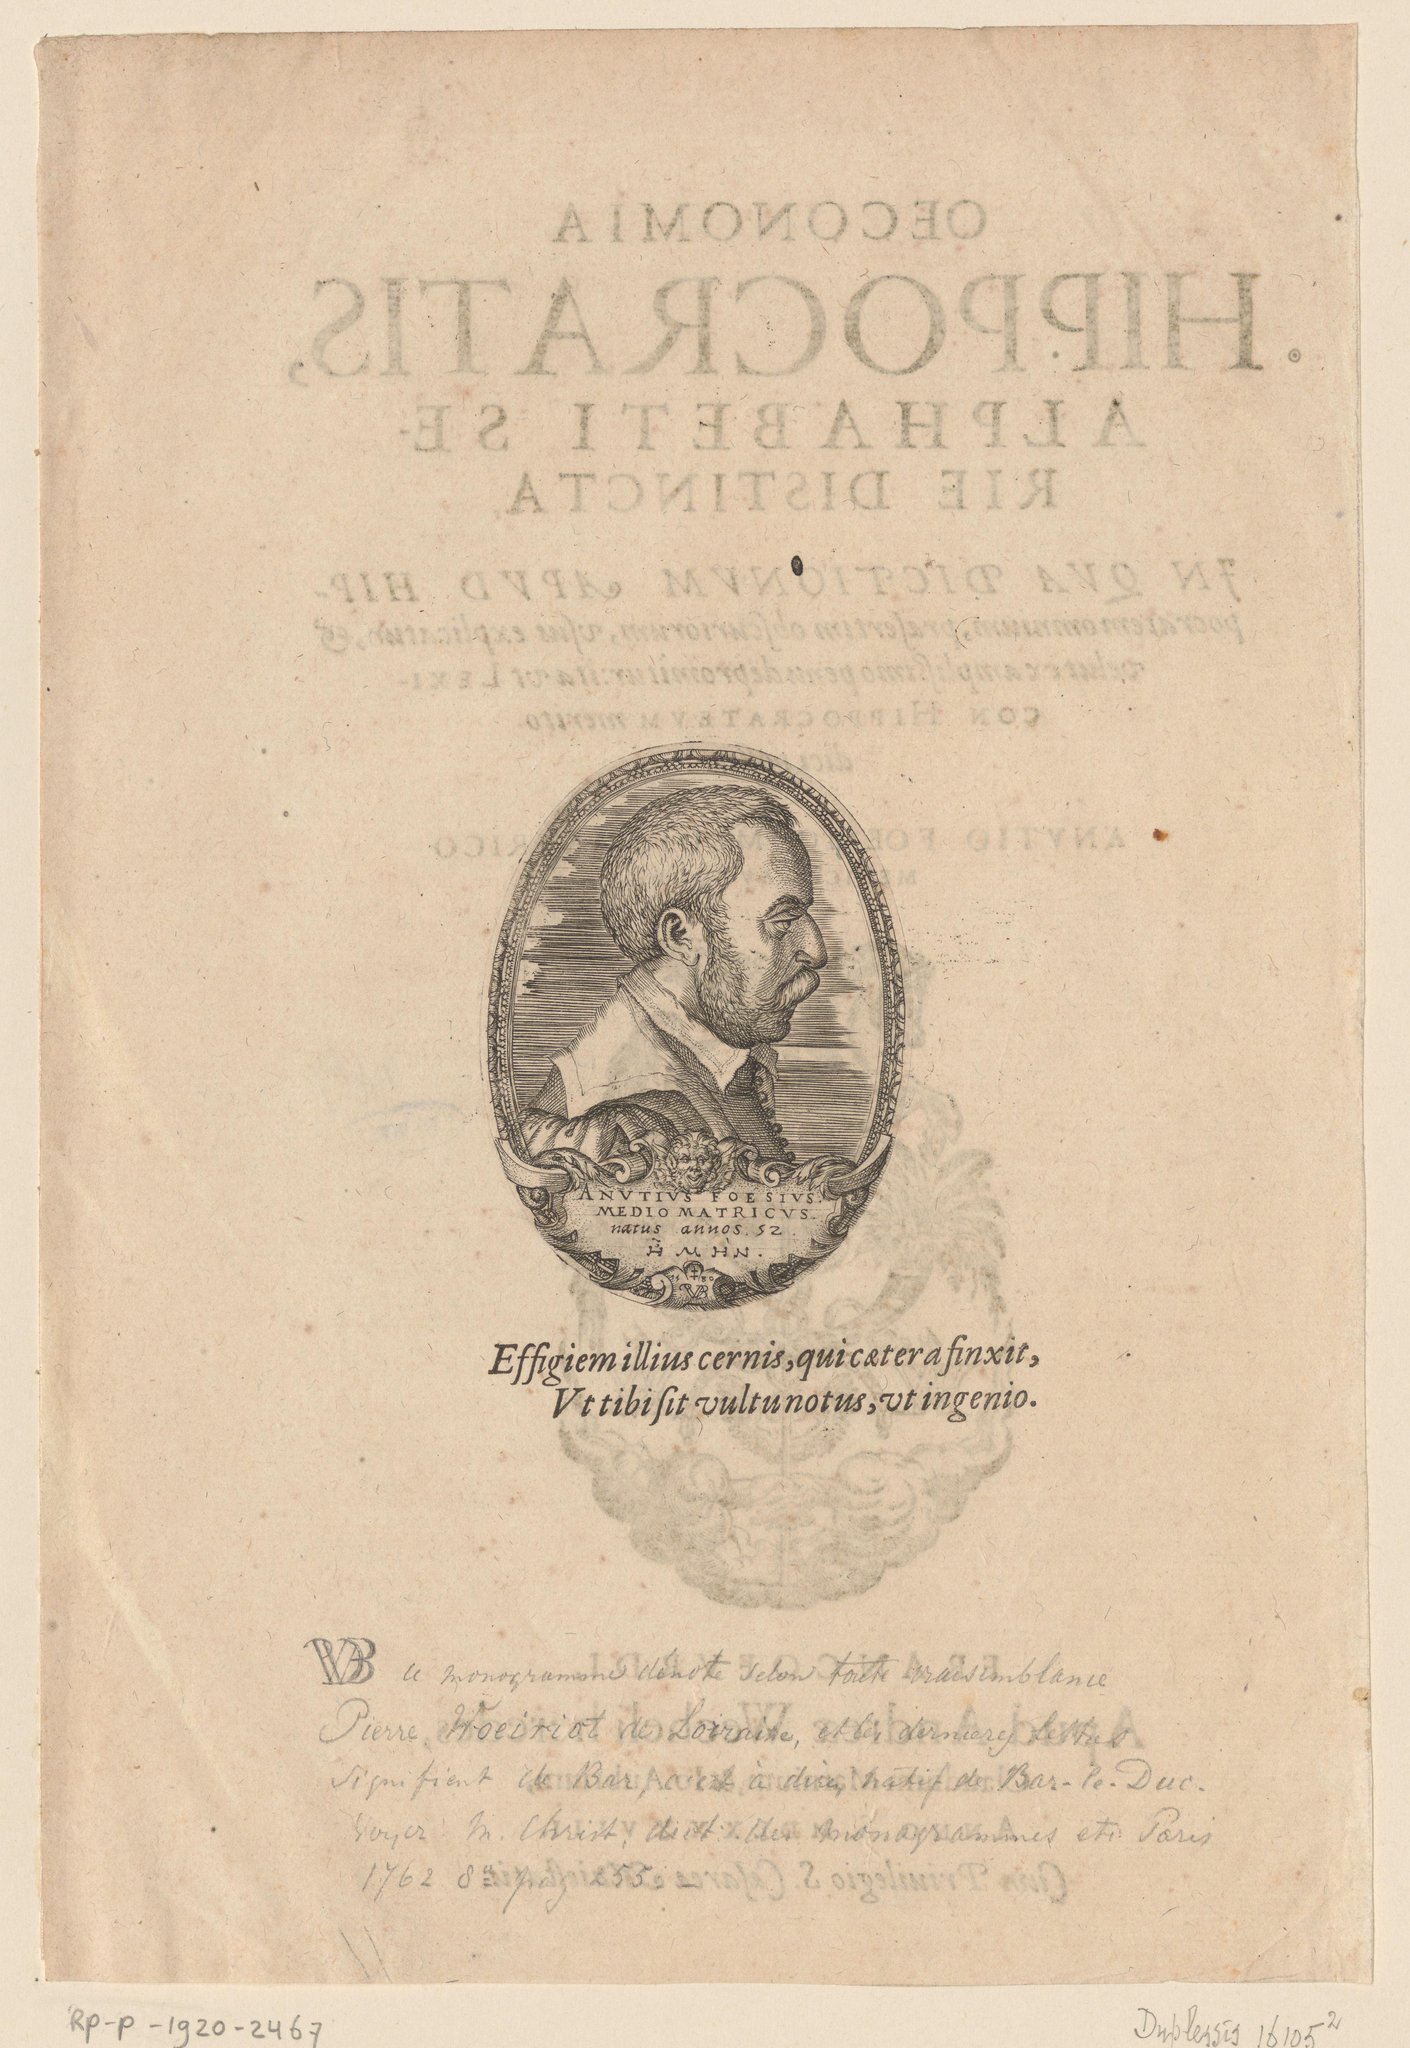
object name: print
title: Portret van Anuce Foës op 52-jarige leeftijd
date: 1588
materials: paper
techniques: engraving, letterpress printing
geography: frankfurt am main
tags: historical persons, physician, doctor (+ portrait of scholar, scientist)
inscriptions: collector's mark: Lugt 2228, inscription: ‘le monogramme dénote selon toute vraisemblance Pierre Woeiriot de Loiraine, (...)’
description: Het verso is de titelpagina voor: Foës, Anuce. Oeconomia Hippocratis, alphabeti serie distincta (...). Frankfurt: André Wechel, 1588.